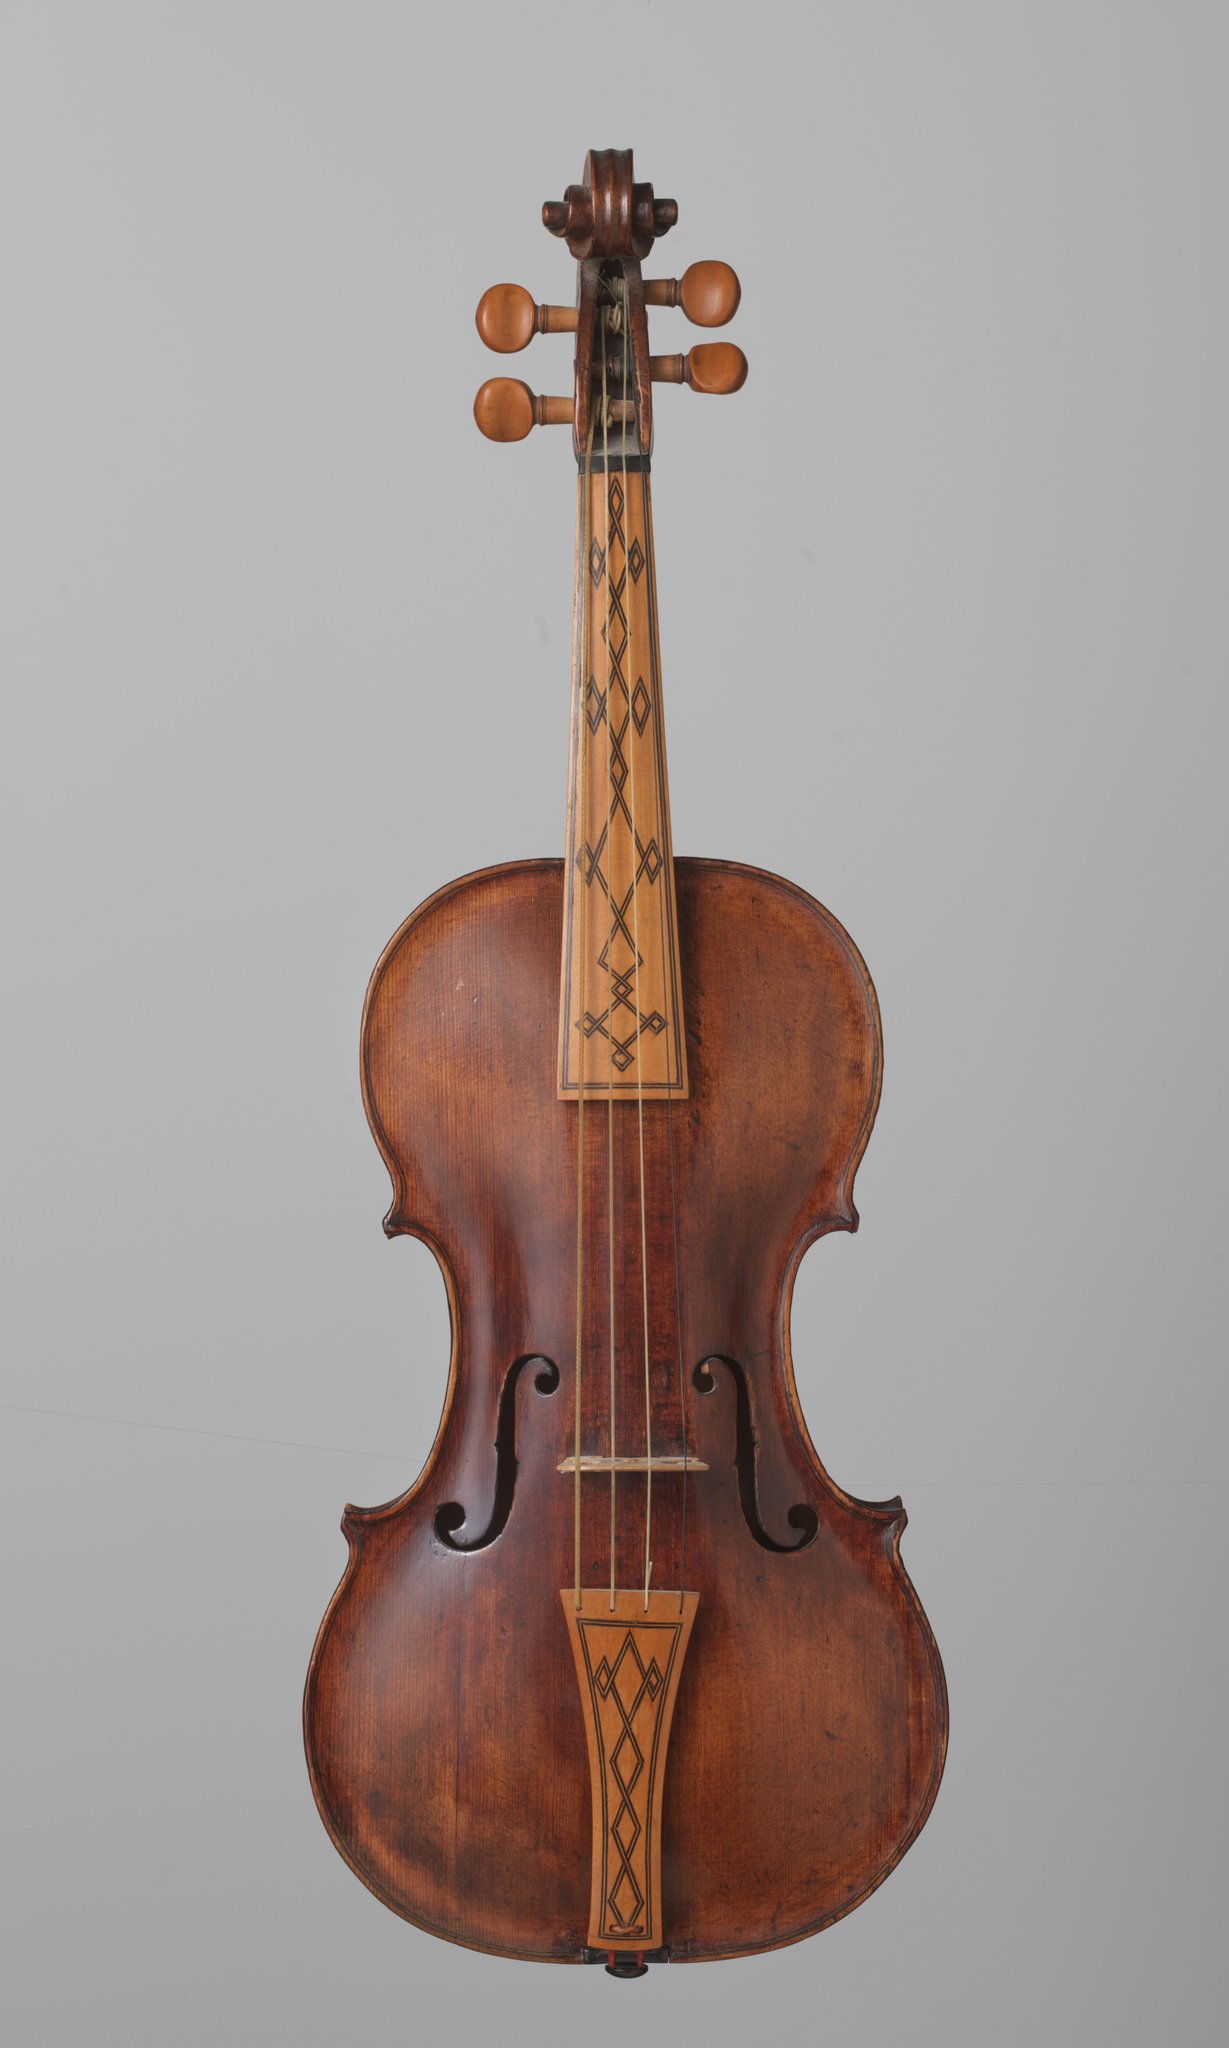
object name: stringed instrument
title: Violin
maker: Anonymous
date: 1700-1750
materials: wood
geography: saxony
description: German violin of the "Spielmann type", probably made in Saxony in the first half of the 18th century. Original neck and bass bar. The neck and upper block are in one piece. The fittings are modern.